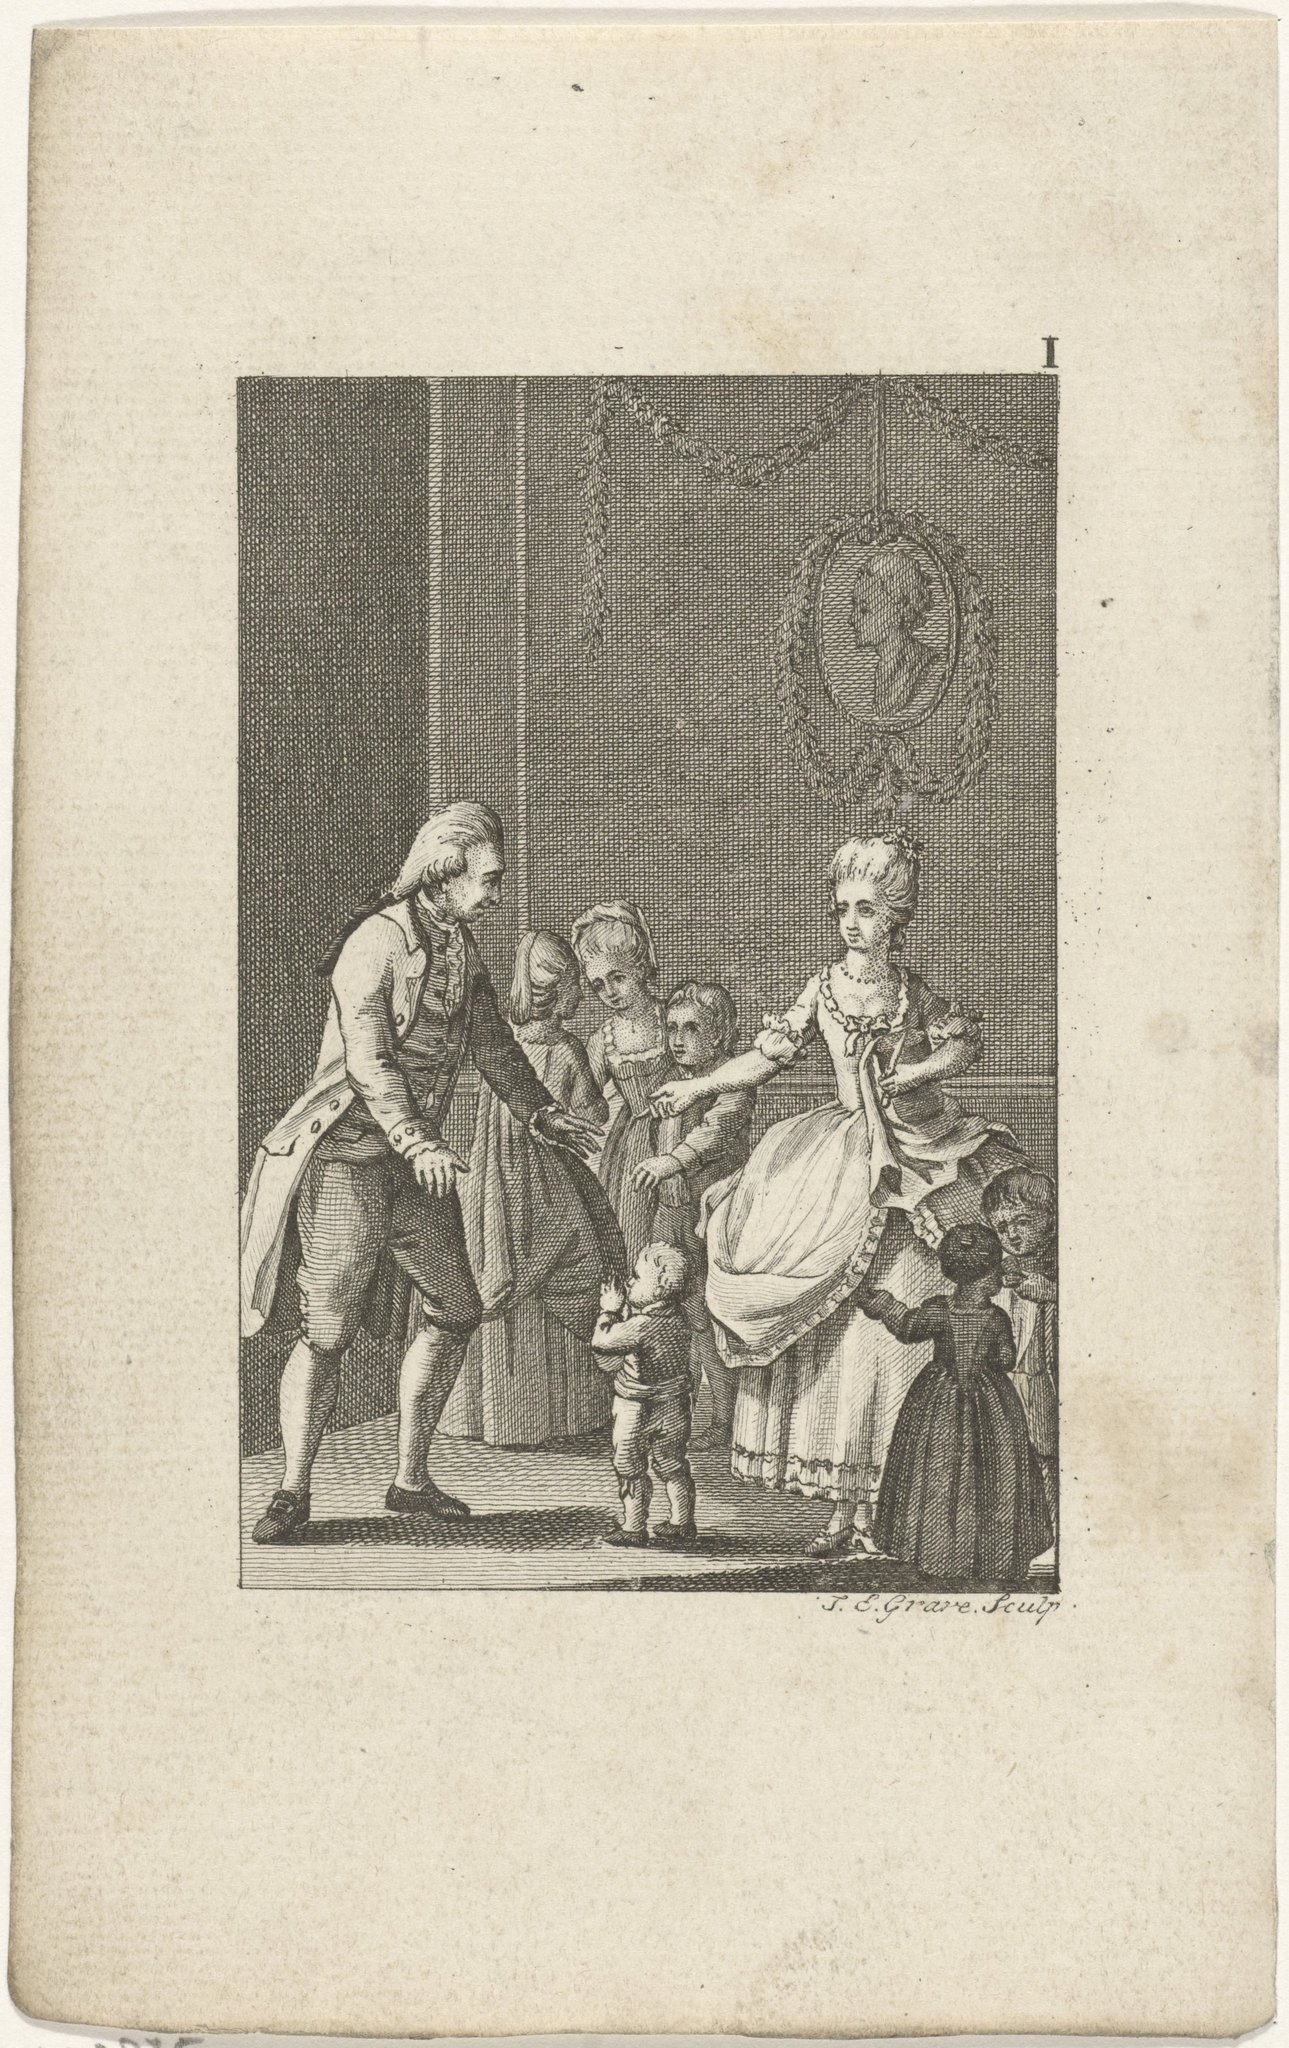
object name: print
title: Scènes uit het leven van de jonge Werther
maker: jan evert grave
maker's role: draughtsman, print maker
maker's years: 1759-1805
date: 1787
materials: paper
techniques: engraving, etching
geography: amsterdam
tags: draughtsman, johann wolfgang von goethe, living-room, parlour, sitting-room, slicing bread, (scenes from) specific works of literature: goethe, werther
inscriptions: collector's mark: Lugt 2228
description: Een woonkamerinterieur. Werther stelt zich voor aan Charlotte. Zij wordt omringd door haar kleinere broers en zussen en is brood voor hen aan het snijden. De prent is deel van een serie met scènes uit Goethe's roman: "Het lijden van de jonge Werther".